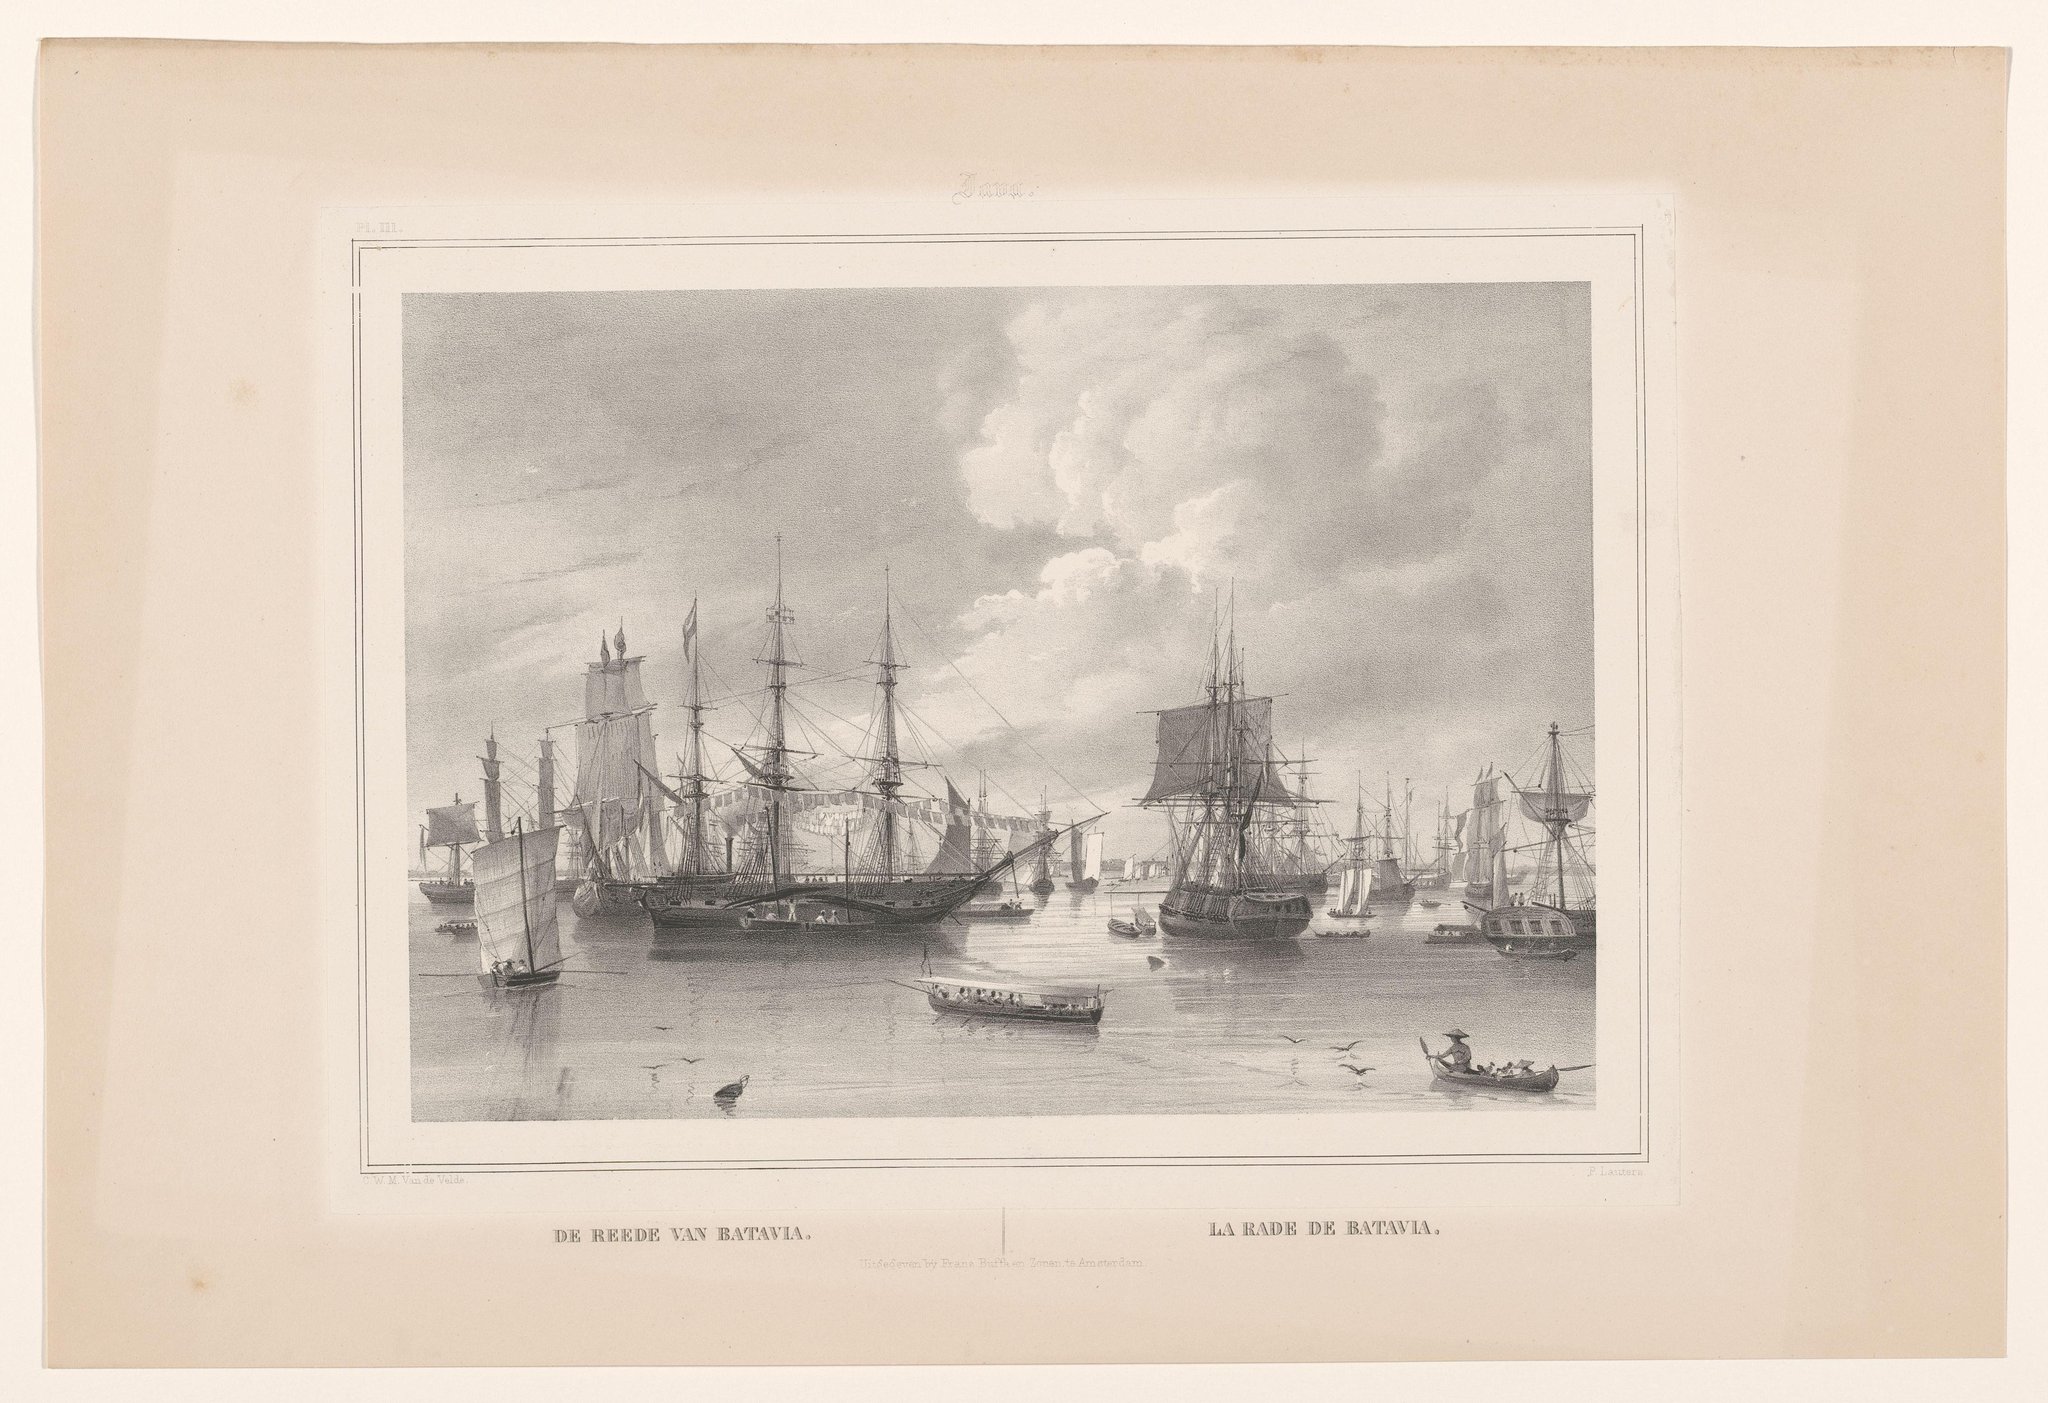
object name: print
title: Gezigten uit Neêrlands Indië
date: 1843-1845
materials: paper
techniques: lithograph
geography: indonesia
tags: harbour, sailing-ship, sailing-boat, parts of ship's exterior: anchor, batavia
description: Voor de haven liggen zeilschepen voor anker. Genummerd linksboven: Pl. III. De prent maakt deel uit van een omslag met dertien bladen.